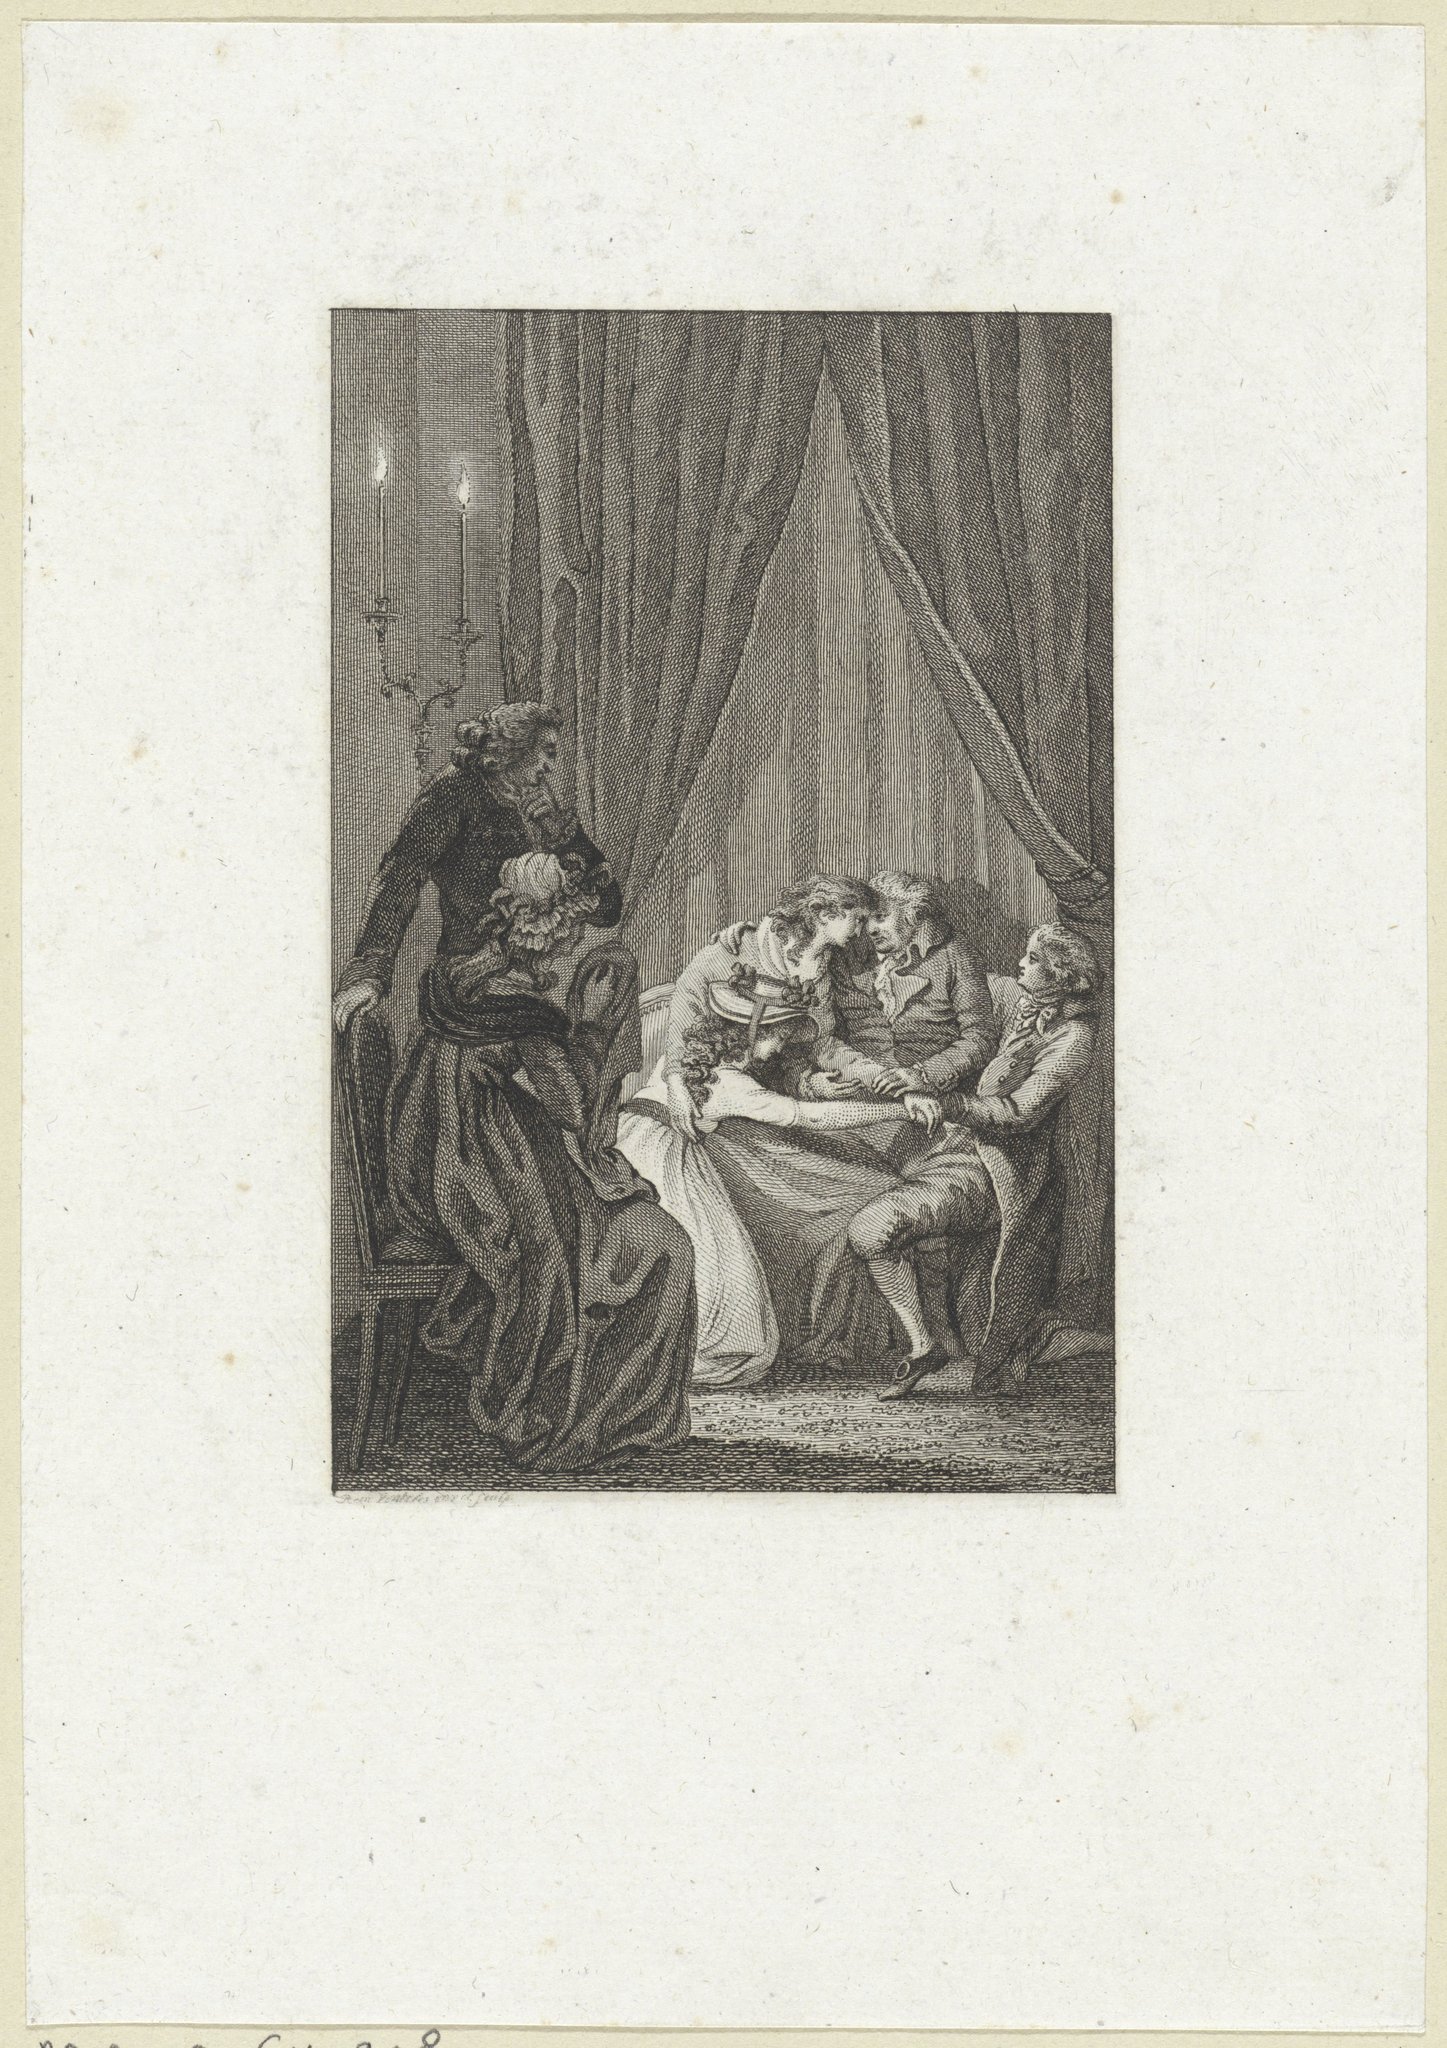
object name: print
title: Treurende familie in een vertrek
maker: reinier vinkeles (i)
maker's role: draughtsman, print maker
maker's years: 1741-1816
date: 1796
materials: paper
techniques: engraving, etching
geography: amsterdam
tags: handkerchief, weeping, family, descendance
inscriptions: collector's mark: Lugt 240